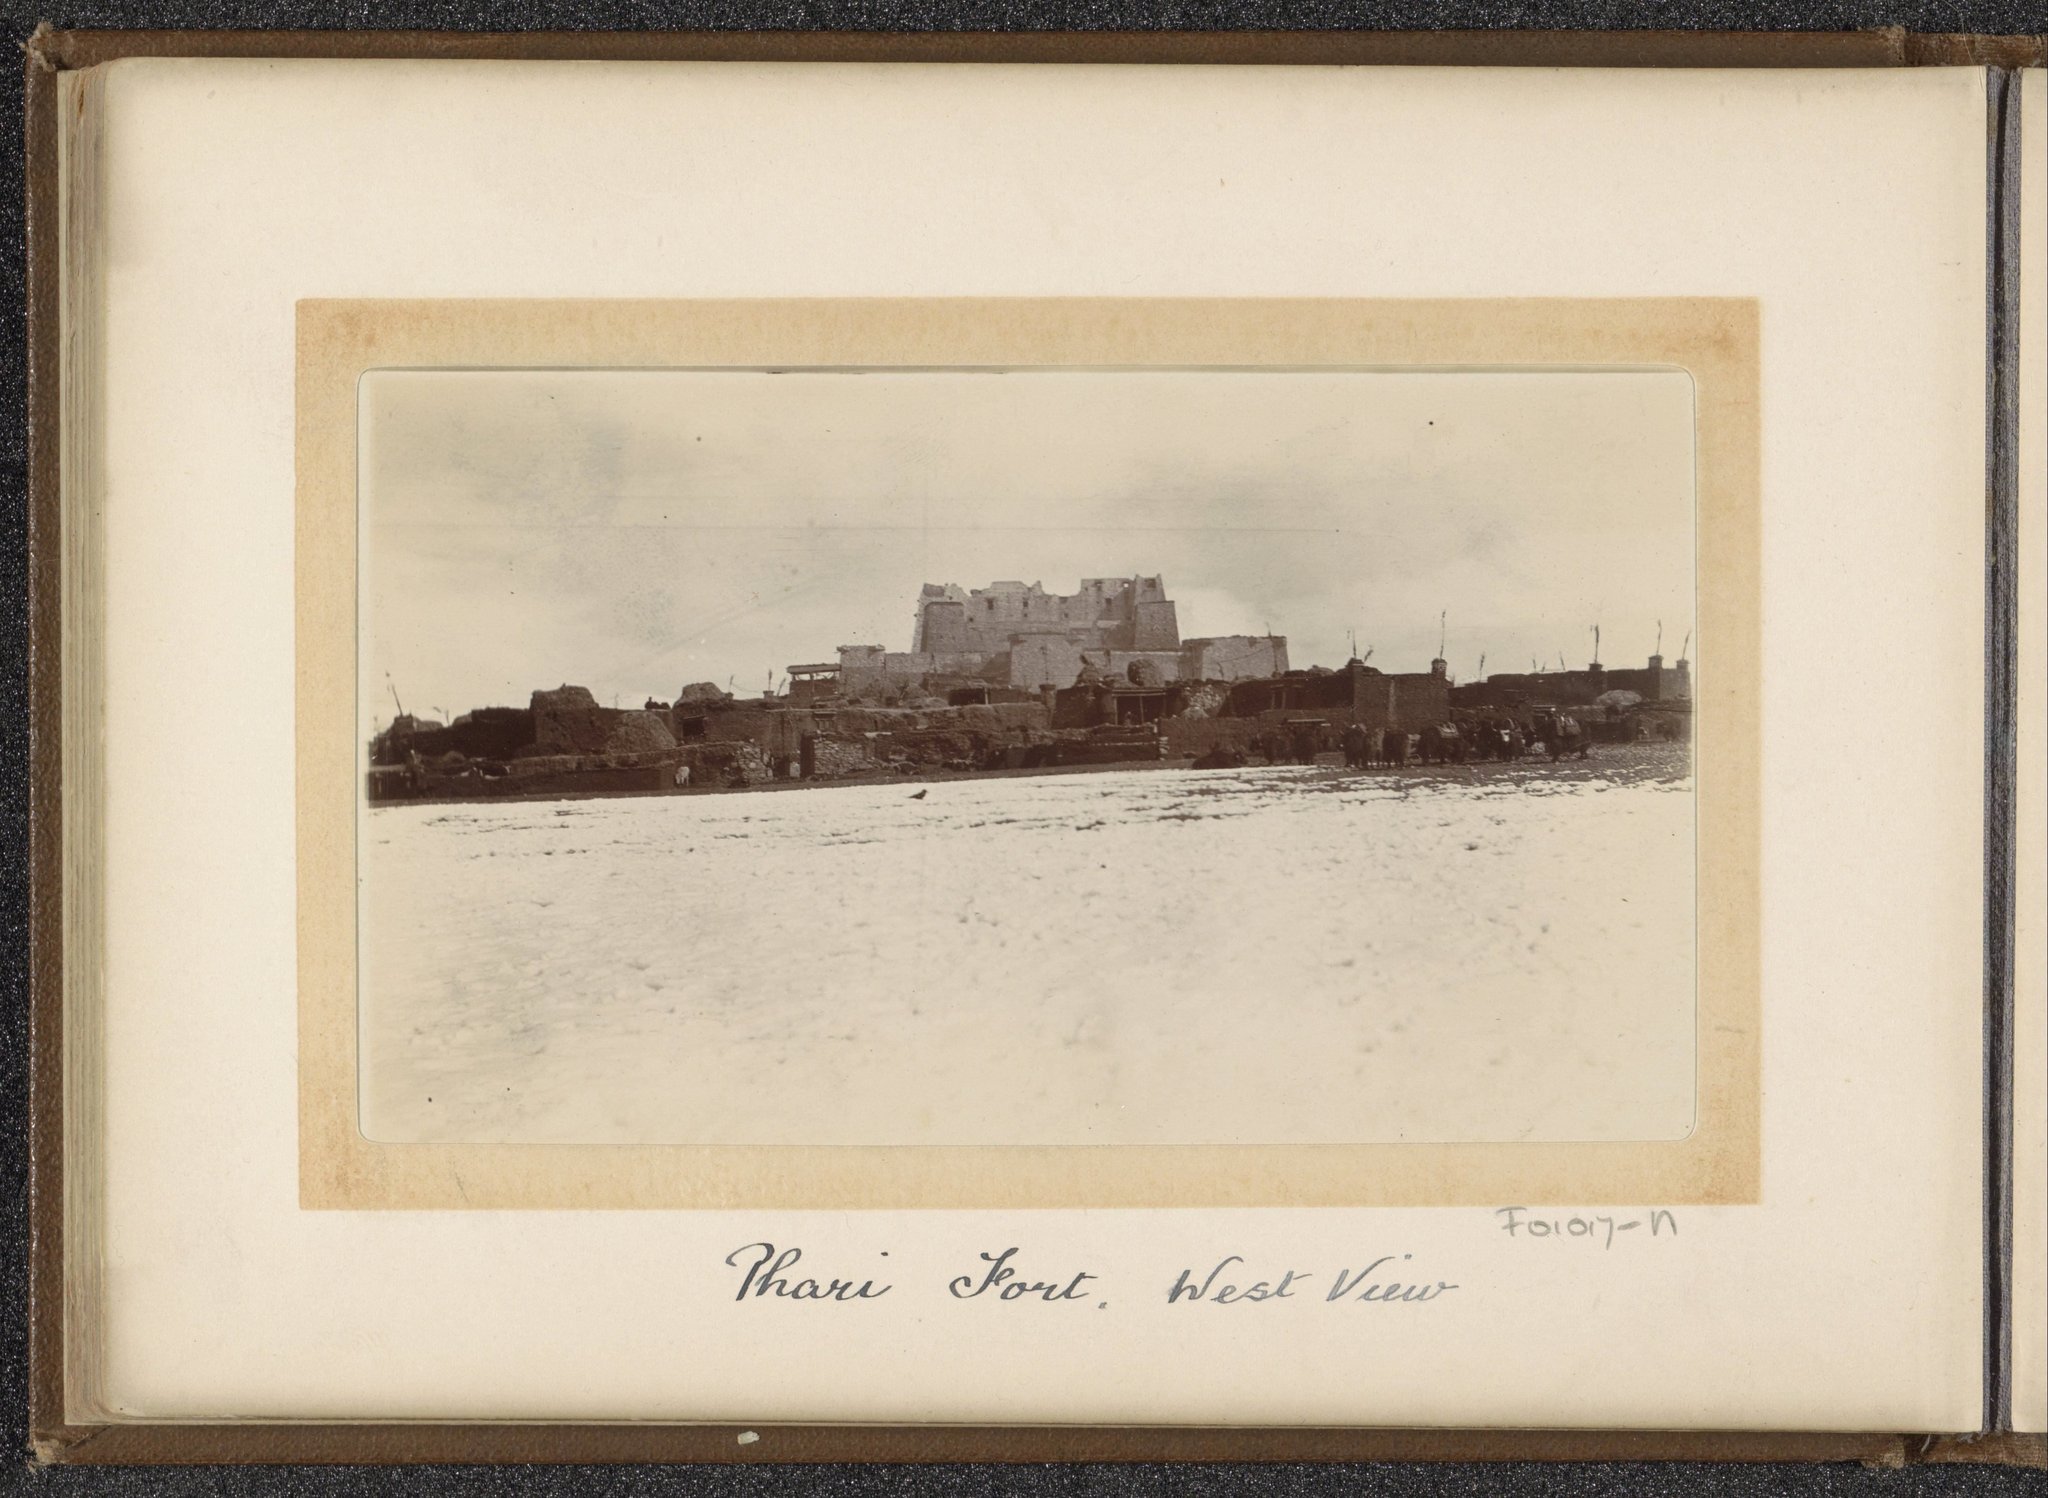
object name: photograph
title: Phari Fort seen from the west with houses and pack animals surrounding it, Tibet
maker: d.t. dalton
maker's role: sergeant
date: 1903-1906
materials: photographic support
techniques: gelatin silver print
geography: phari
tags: pack-animal, fortress, snow, hut, cabin, lodge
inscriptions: title: ‘Phari Fort. West View’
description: Onderdeel van Fotoalbum met 24 foto's van de reis van legertelegrafist D.T. Dalton door Tibet.